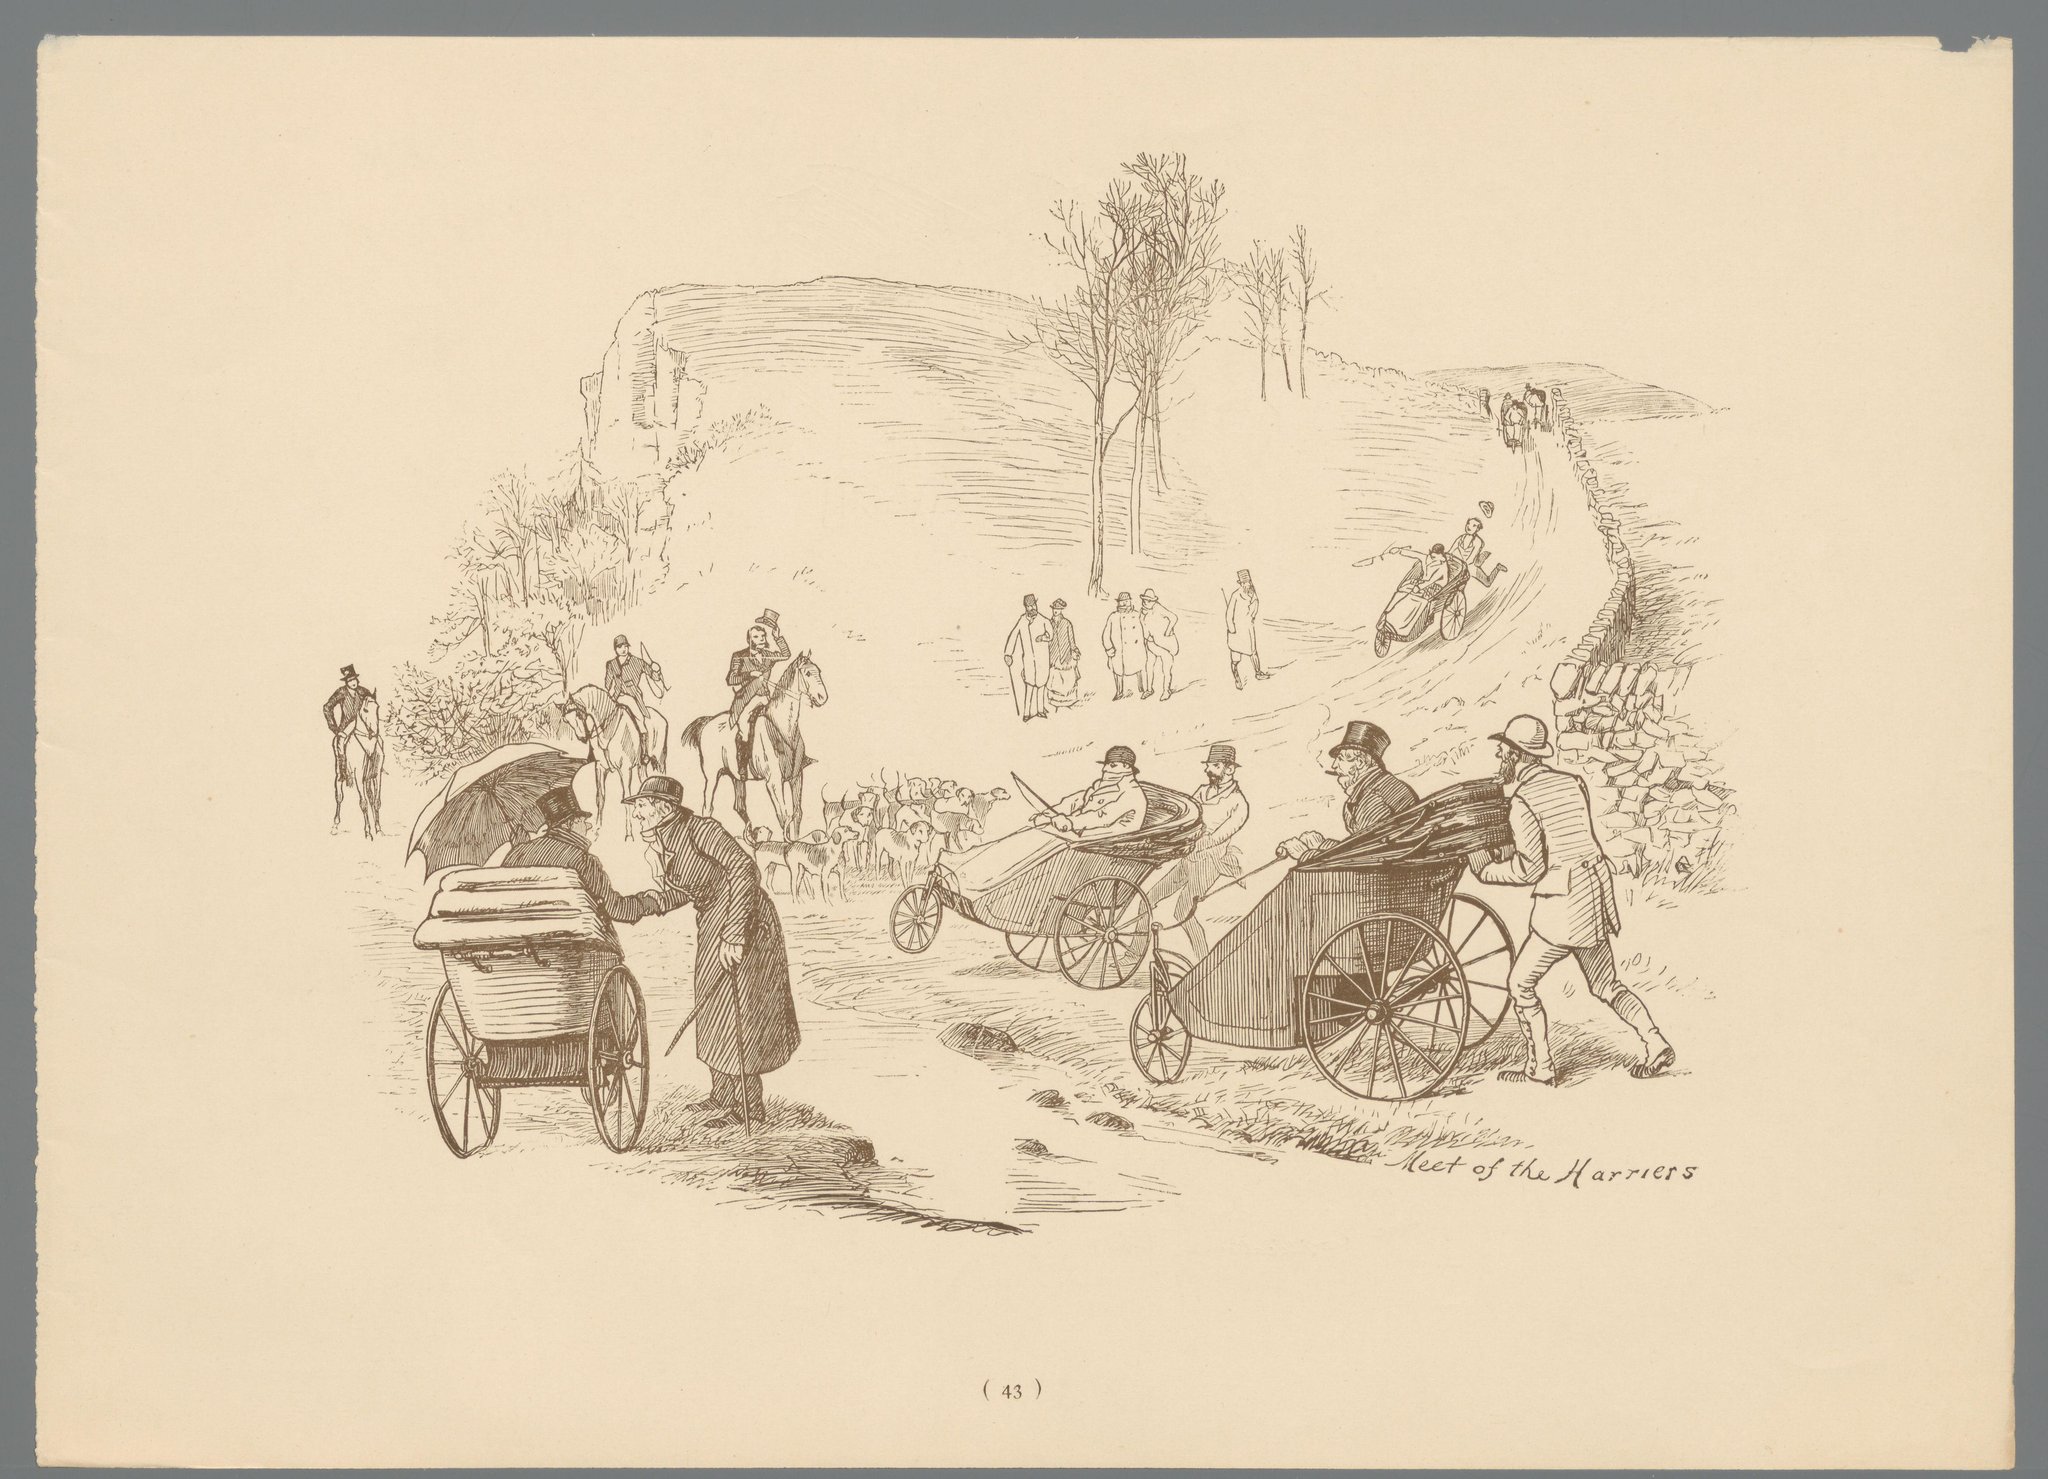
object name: book illustration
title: Meet of the Harriers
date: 1889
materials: paper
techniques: letterpress printing, engraving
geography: london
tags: hunting, chase, traffic on land, open-air recreation, landscapes (+ landscape with figures, staffage)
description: Prent uit: Gleanings from the Graphic. Londen: George Routledge & Sons, 1889. Dit werk is een bundel van diverse illustraties die eerder verschenen in verschillende jaargangen van het Engelse weekblad 'The Graphic'. De bundel is na het overlijden van Randolph Caldecott uitgegeven.